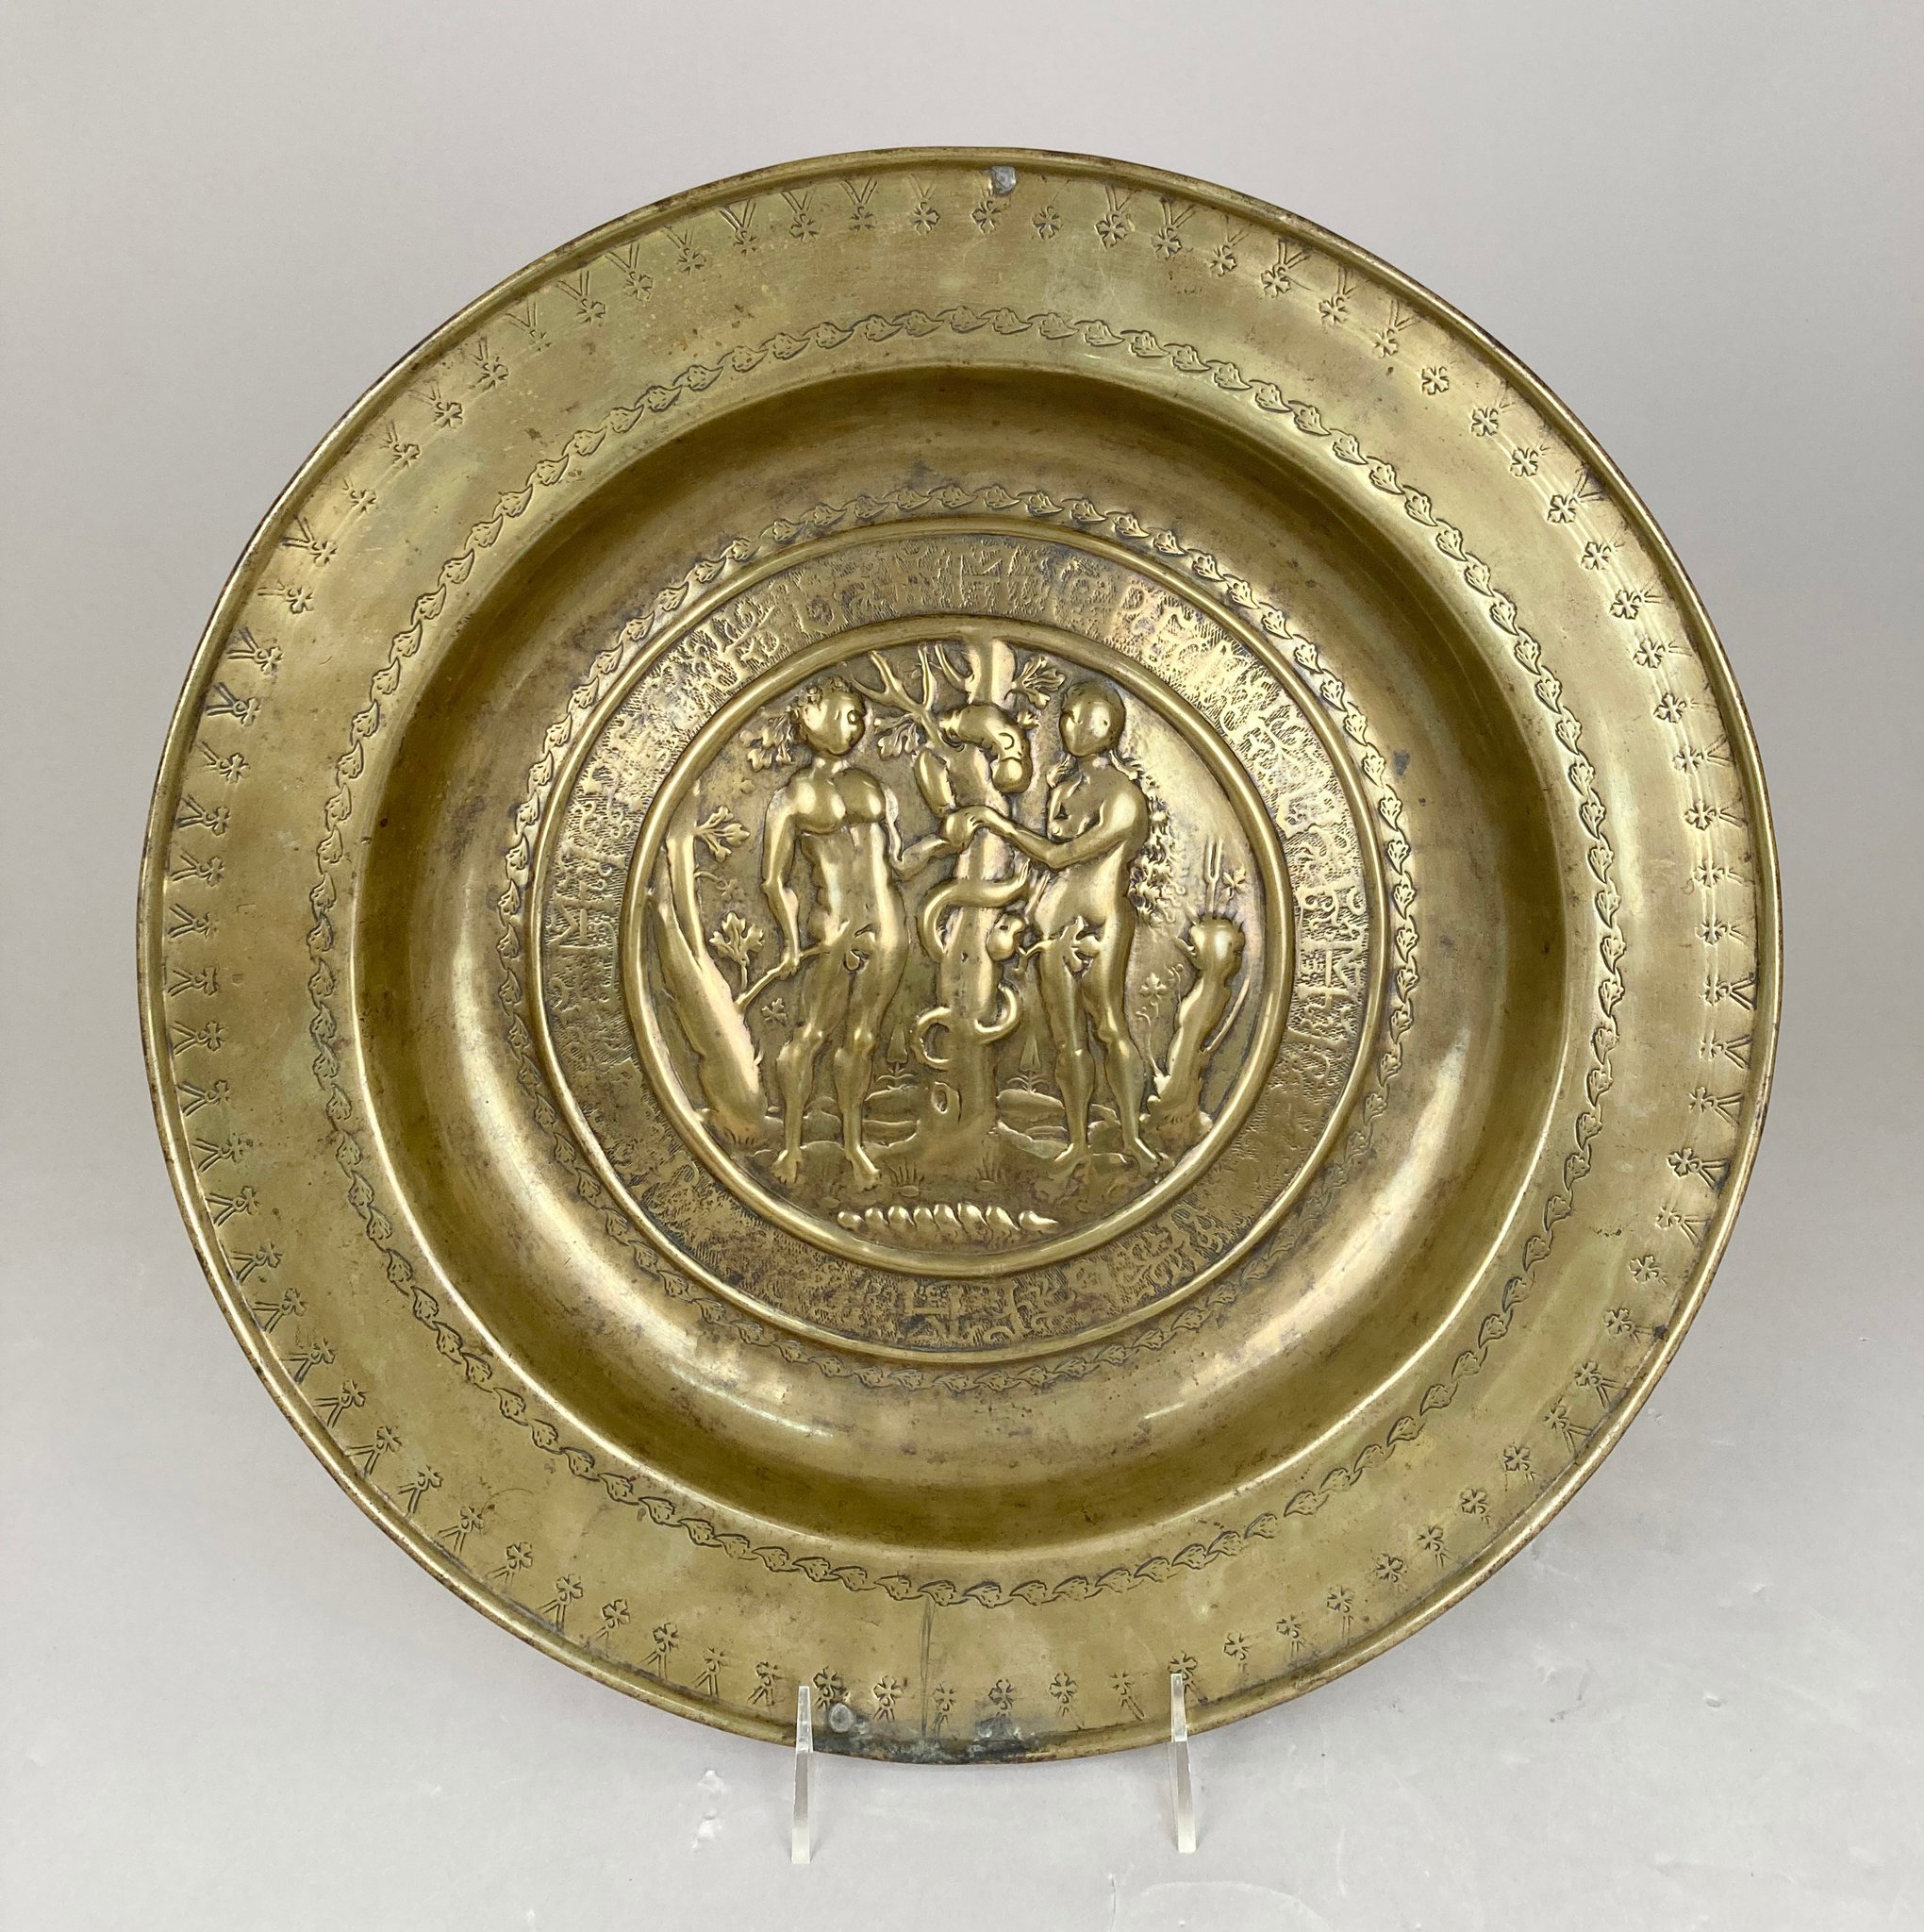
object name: plate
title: Plate with representation of Adam and Eve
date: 1500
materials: brass